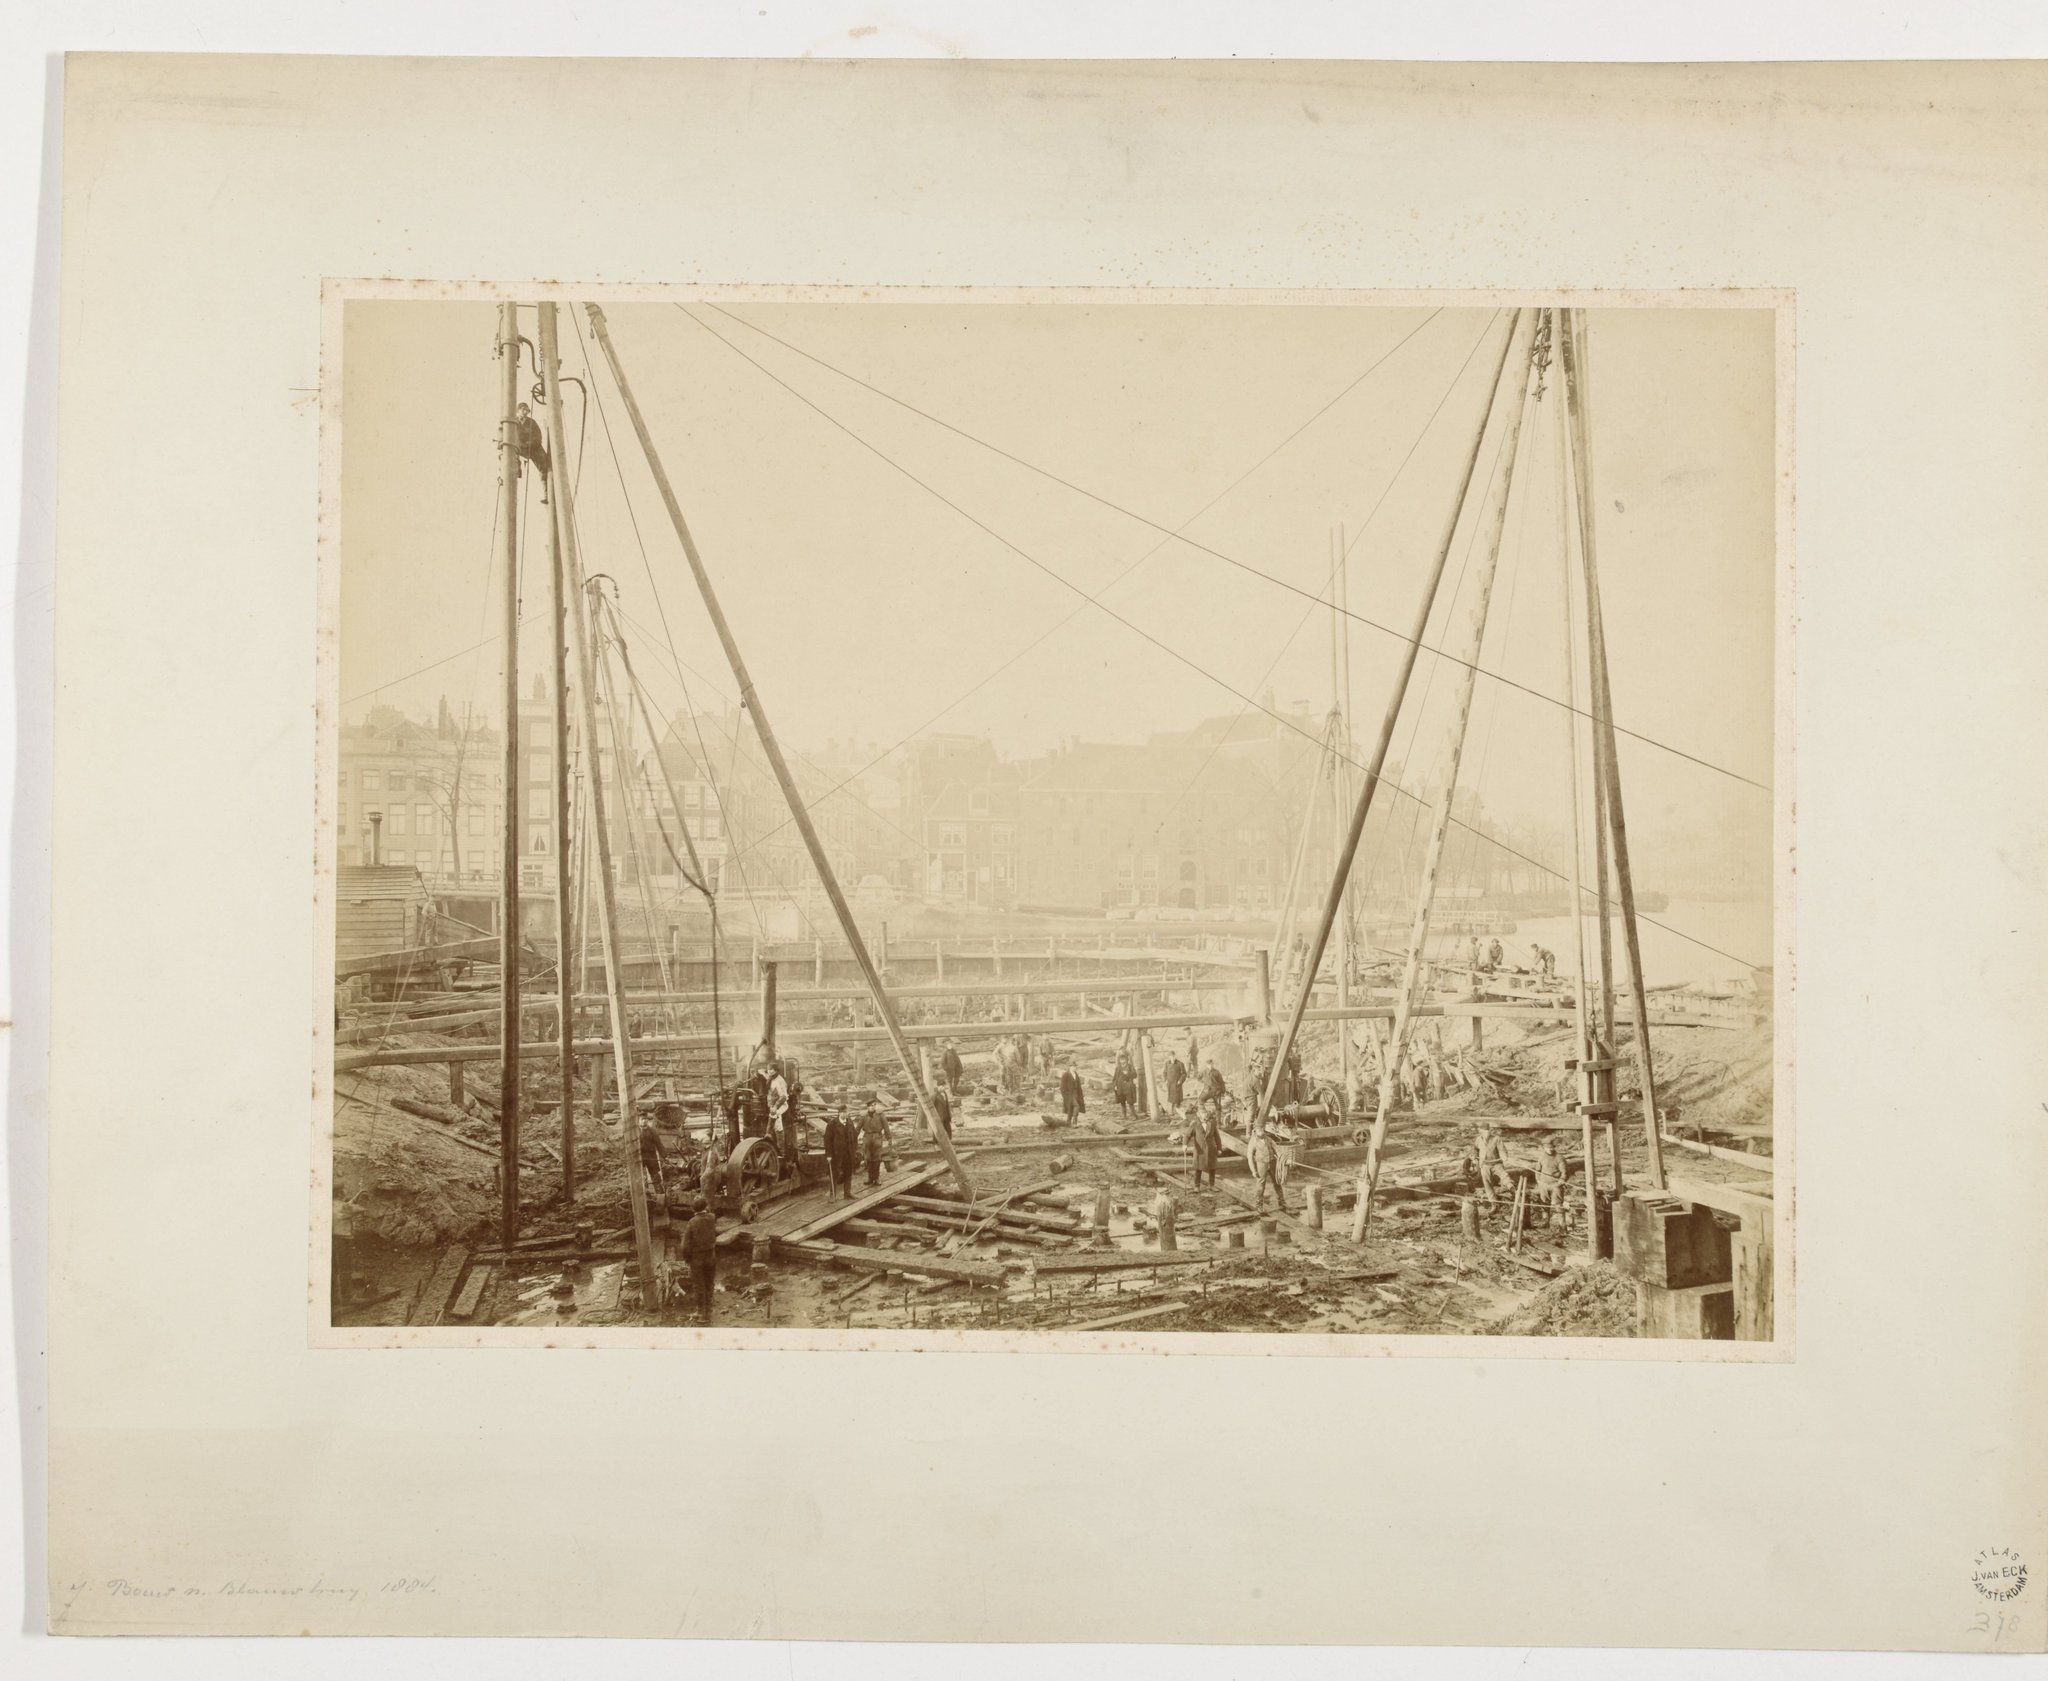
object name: photograph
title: Bouw van de Blauwbrug in Amsterdam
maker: Anonymous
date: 1883-1884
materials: cardboard, photographic support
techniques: albumen print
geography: netherlands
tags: building activities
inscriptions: stamp: ‘Atlas J. van Eck Amsterdam’